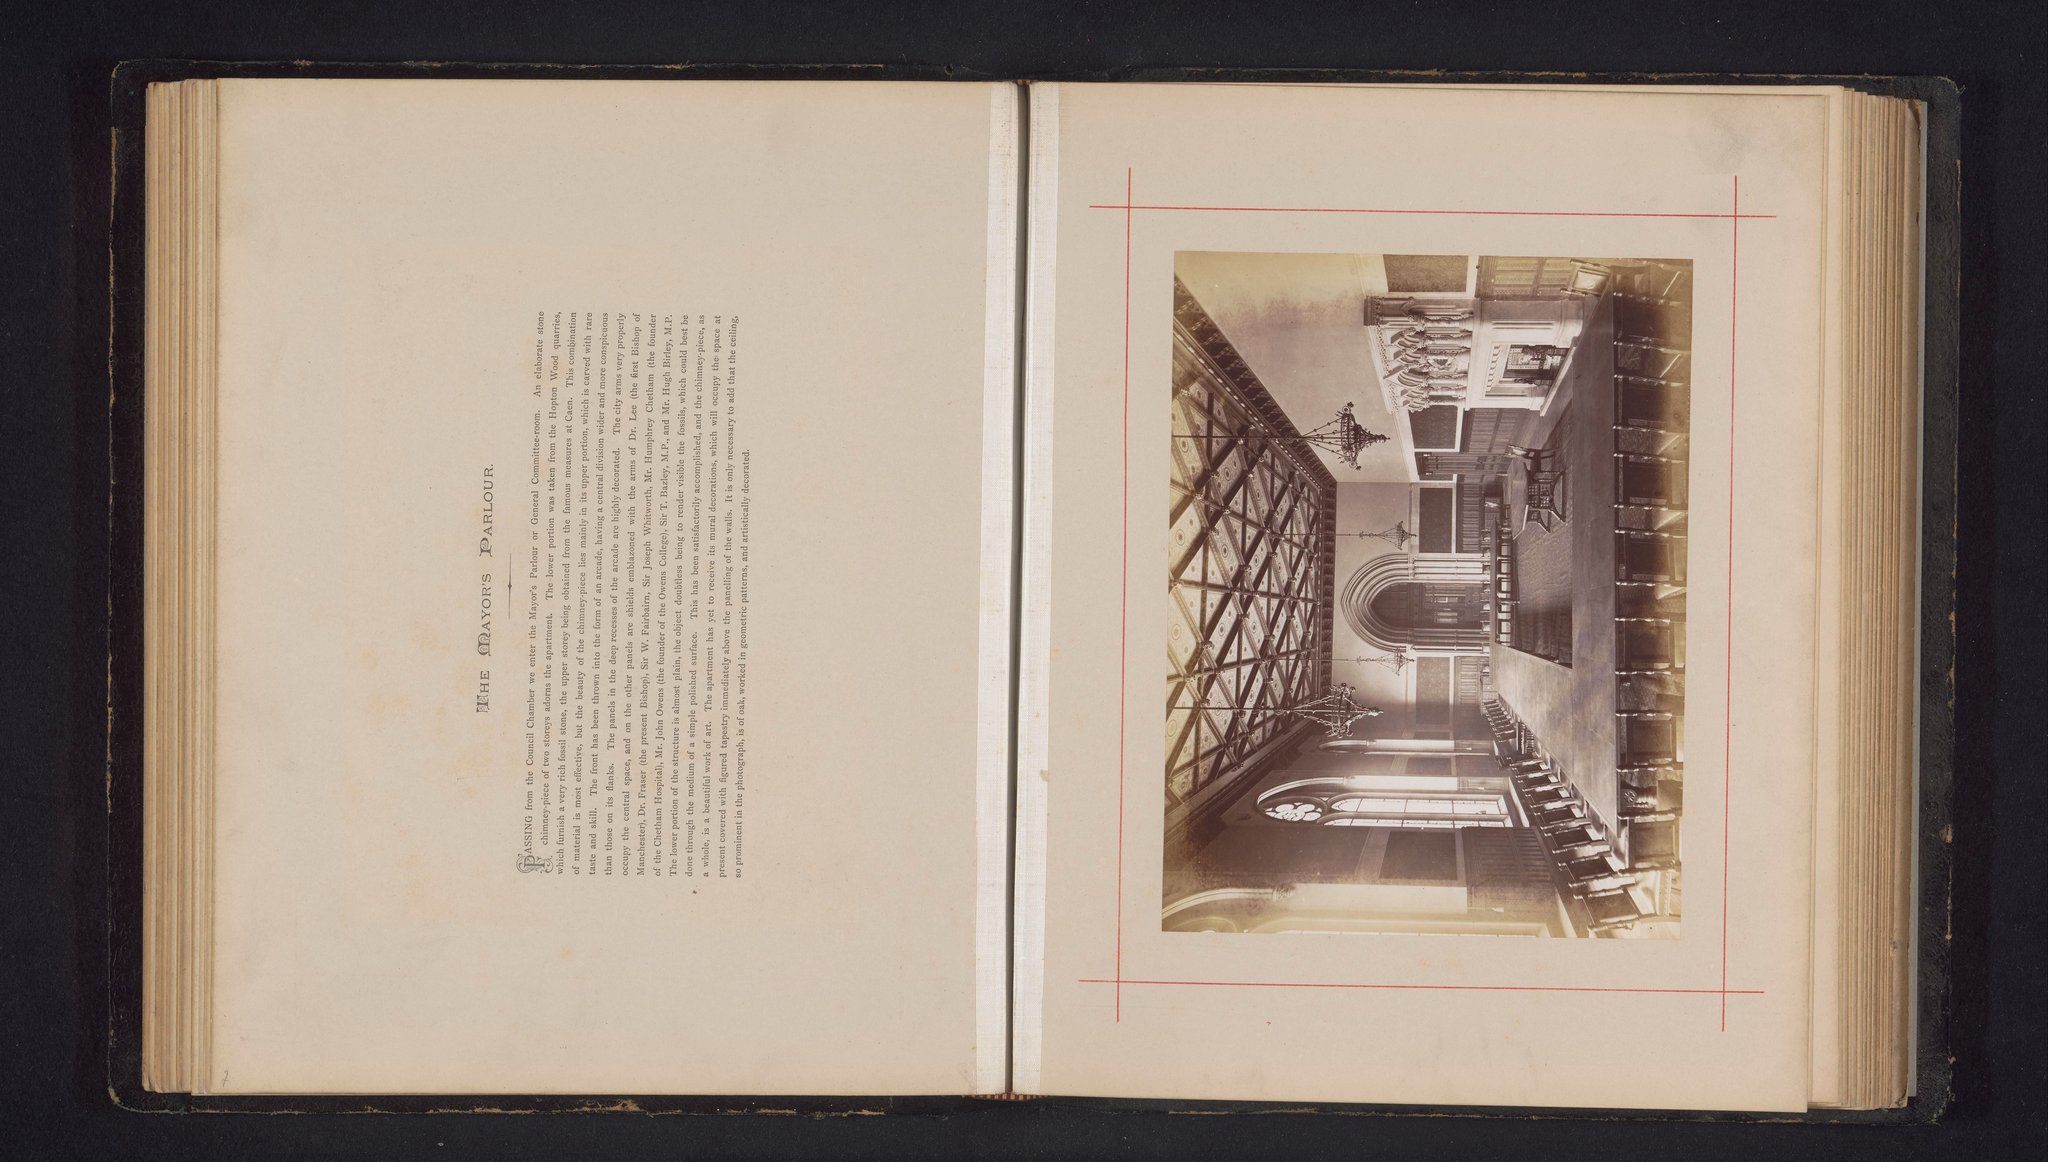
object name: page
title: Salon van de burgemeester in het Stadhuis van Manchester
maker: j. mcleod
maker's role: fotograaf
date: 1877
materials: photographic support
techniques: albumen print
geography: manchester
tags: townhall, interior ~ representation of a building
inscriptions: title: ‘The Mayor's Parlour’